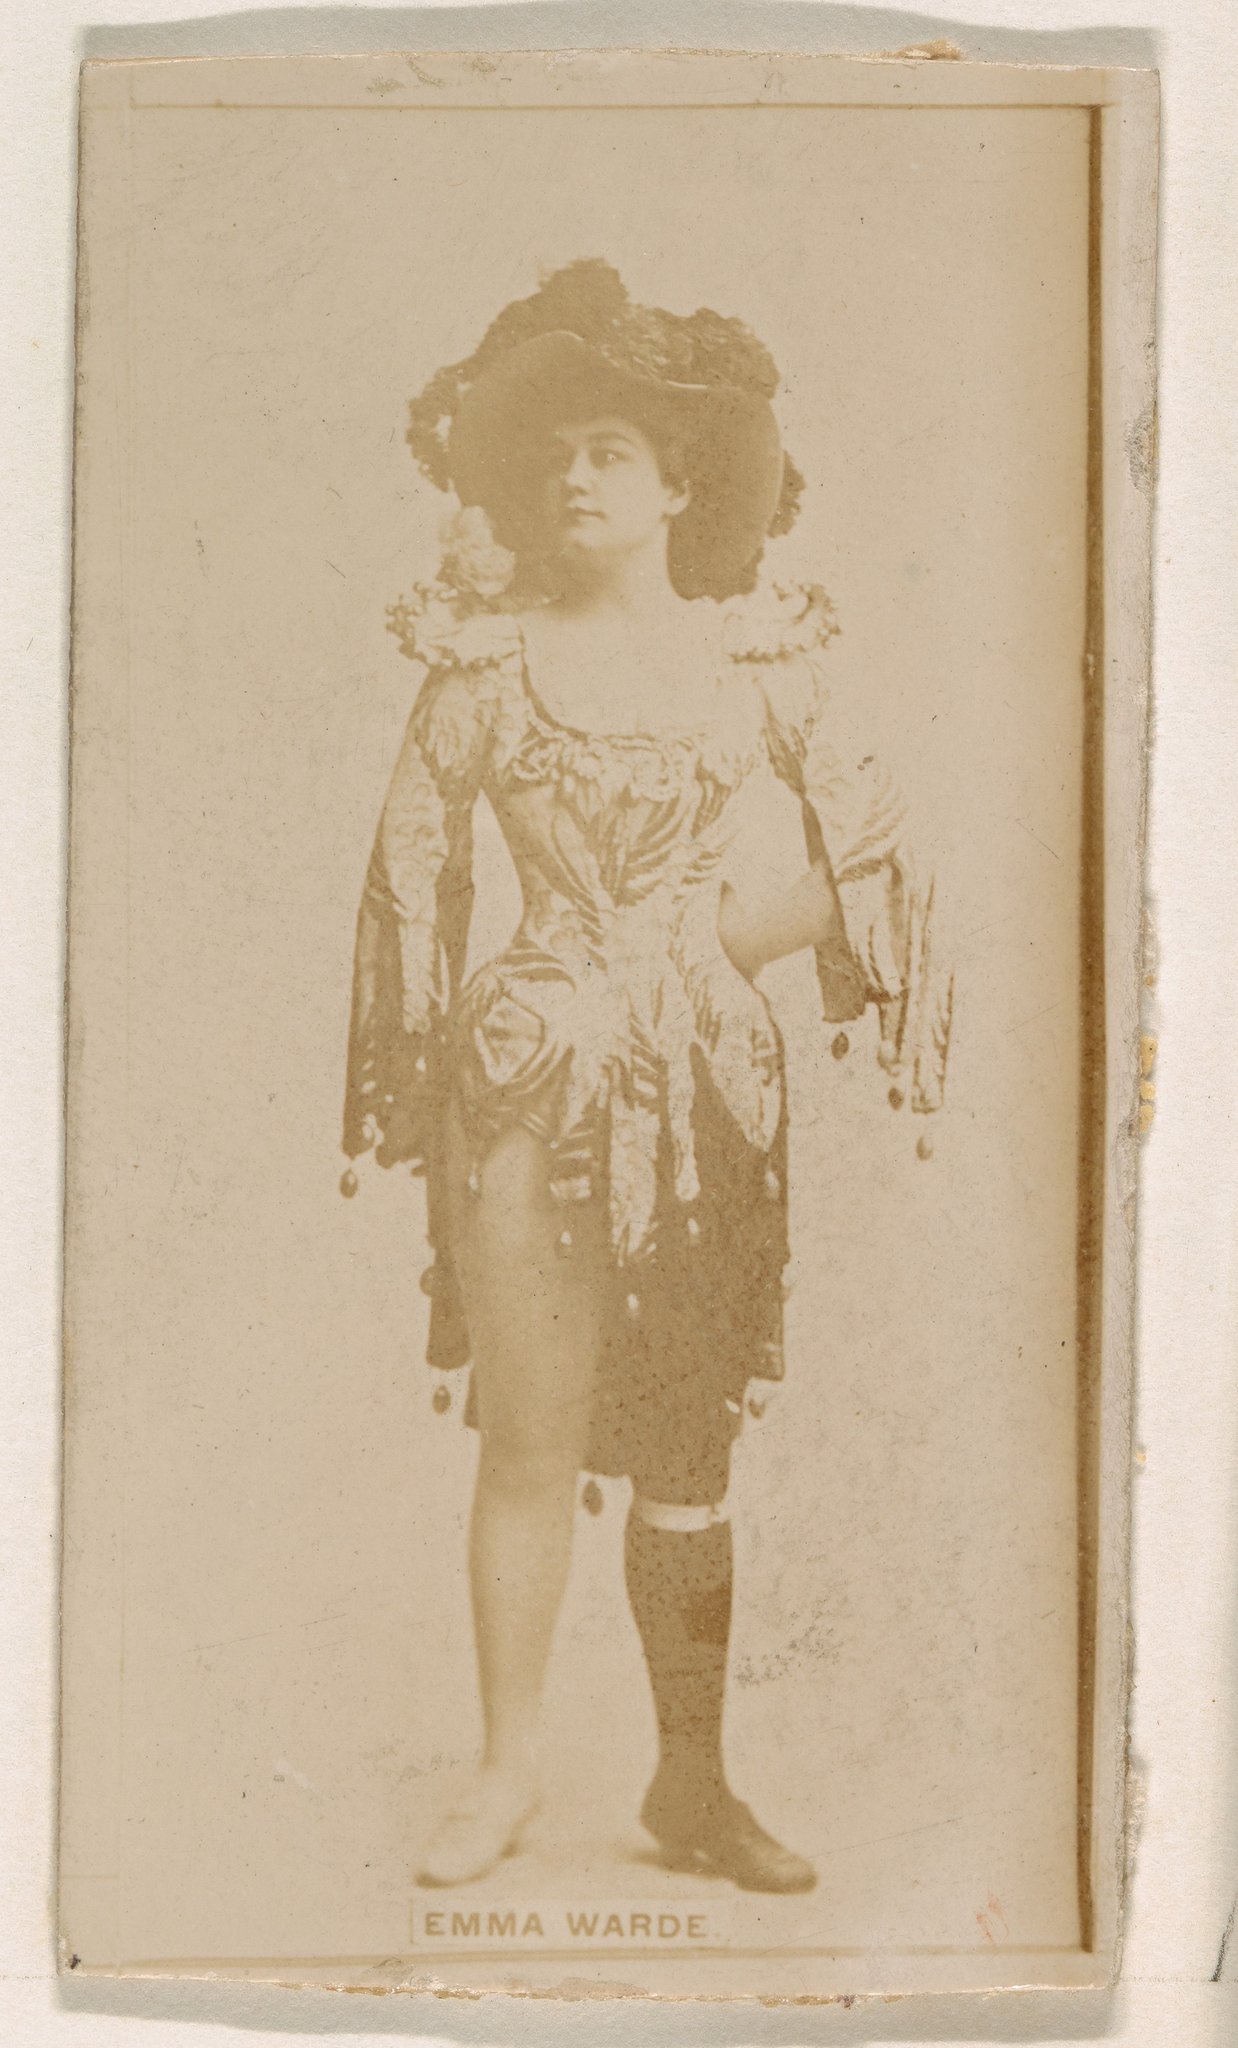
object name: photograph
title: Emma Warde, from the Actresses series (N245) issued by Kinney Brothers to promote Sweet Caporal Cigarettes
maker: kinney brothers tobacco company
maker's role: publisher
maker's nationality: american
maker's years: 1869-2011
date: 1890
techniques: albumen silver print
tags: portraits,women,actresses